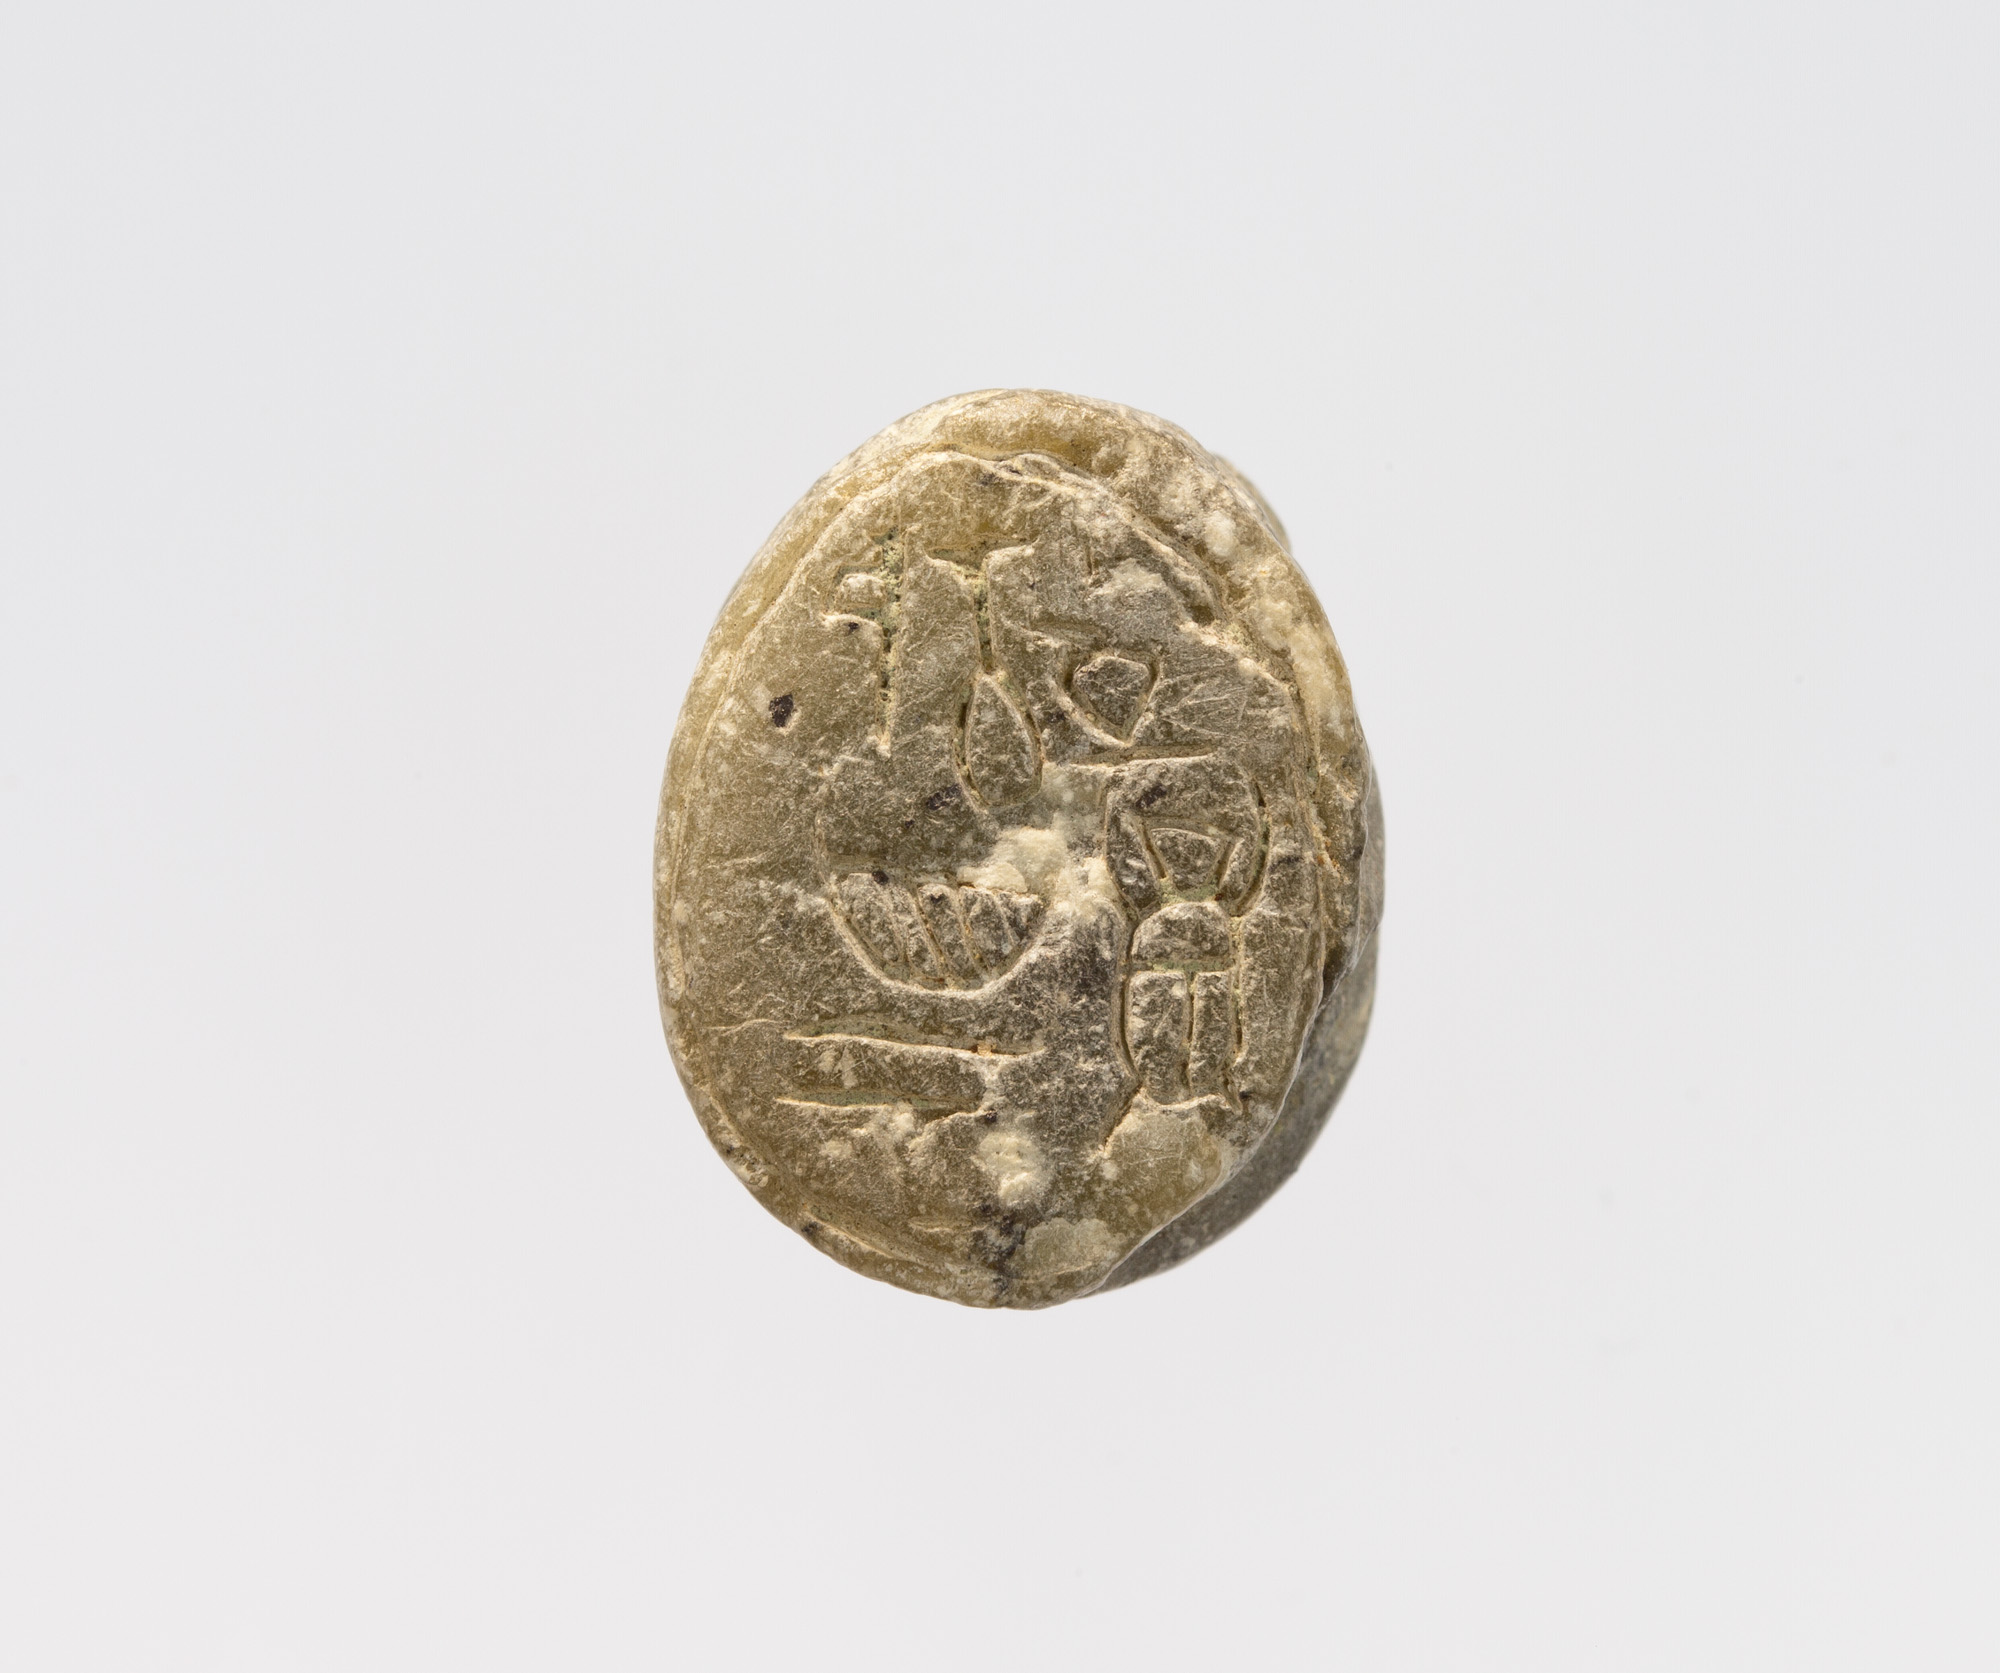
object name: scarab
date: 1479-1458 BCE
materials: faience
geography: egypt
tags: scarabs